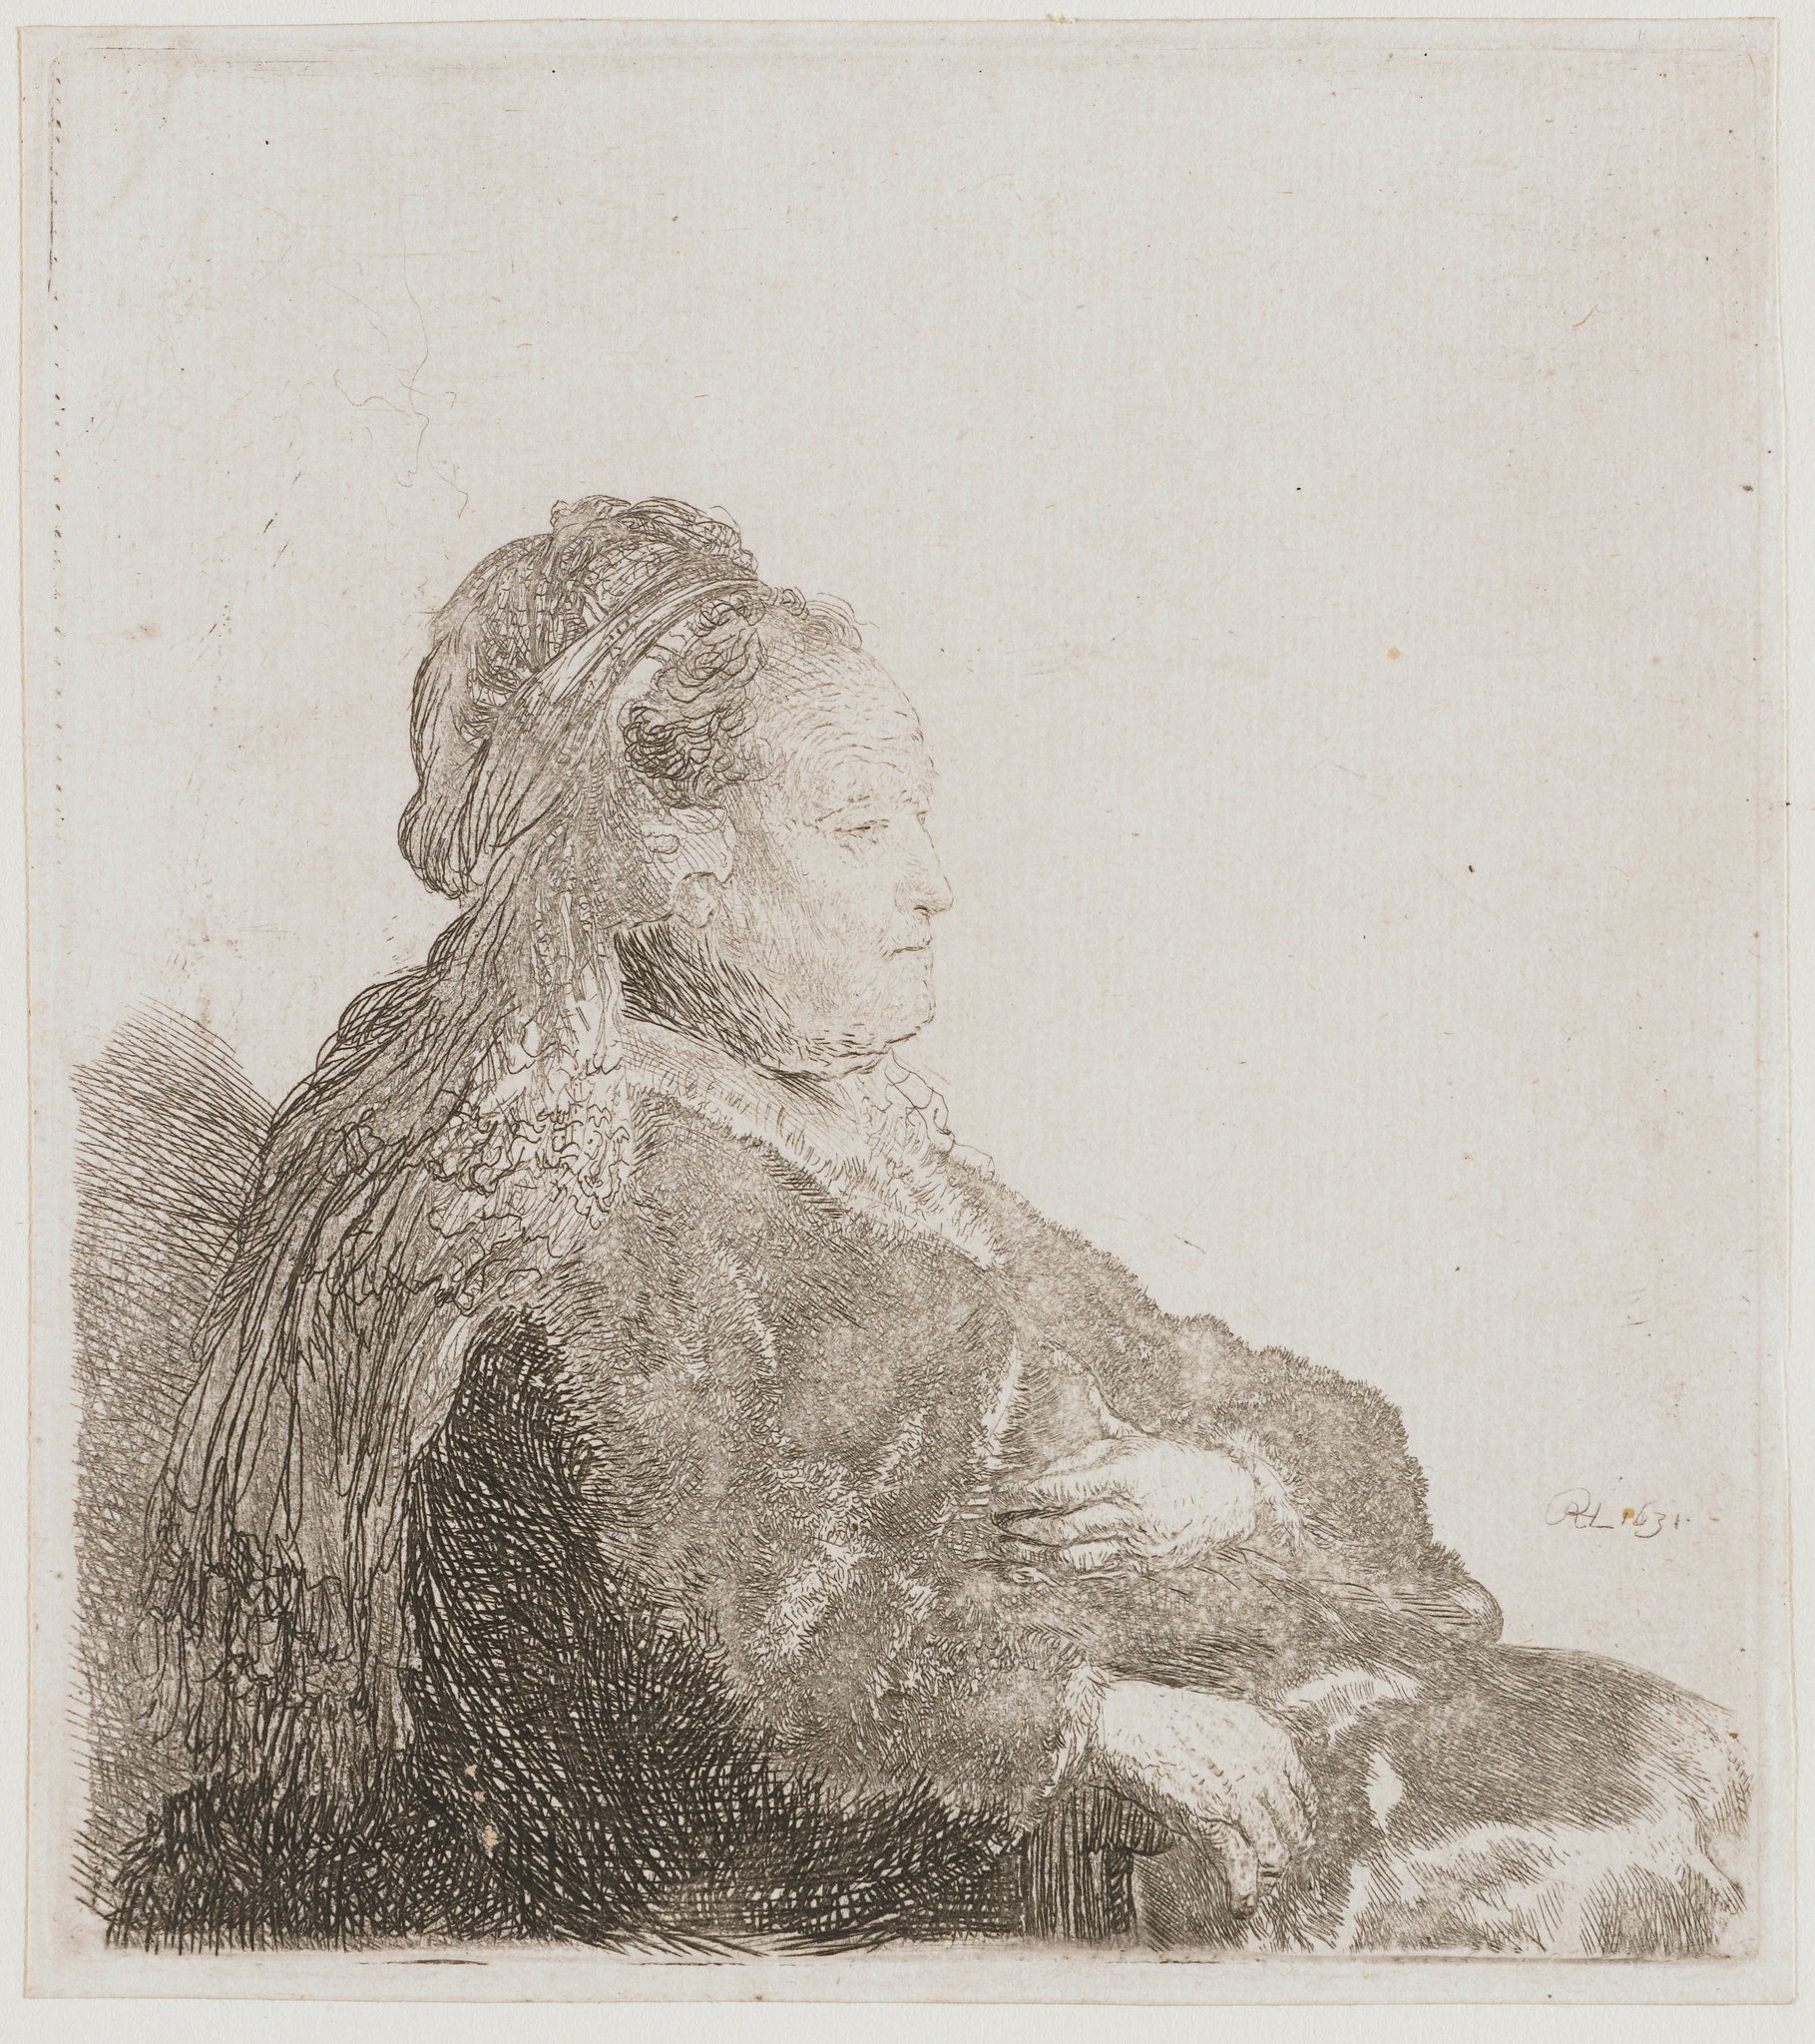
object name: print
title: The artist's mother seated, in an oriental headdress: half length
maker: rembrandt van rijn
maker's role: draughtsman, painter, print maker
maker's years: 1606-1669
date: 1631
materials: paper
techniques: etching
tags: neeltje willemsdr. zuytbrouck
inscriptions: monogram and date: ‘RHL 1631’, collector's mark: Lugt 2228, collector's mark: Lugt 2610